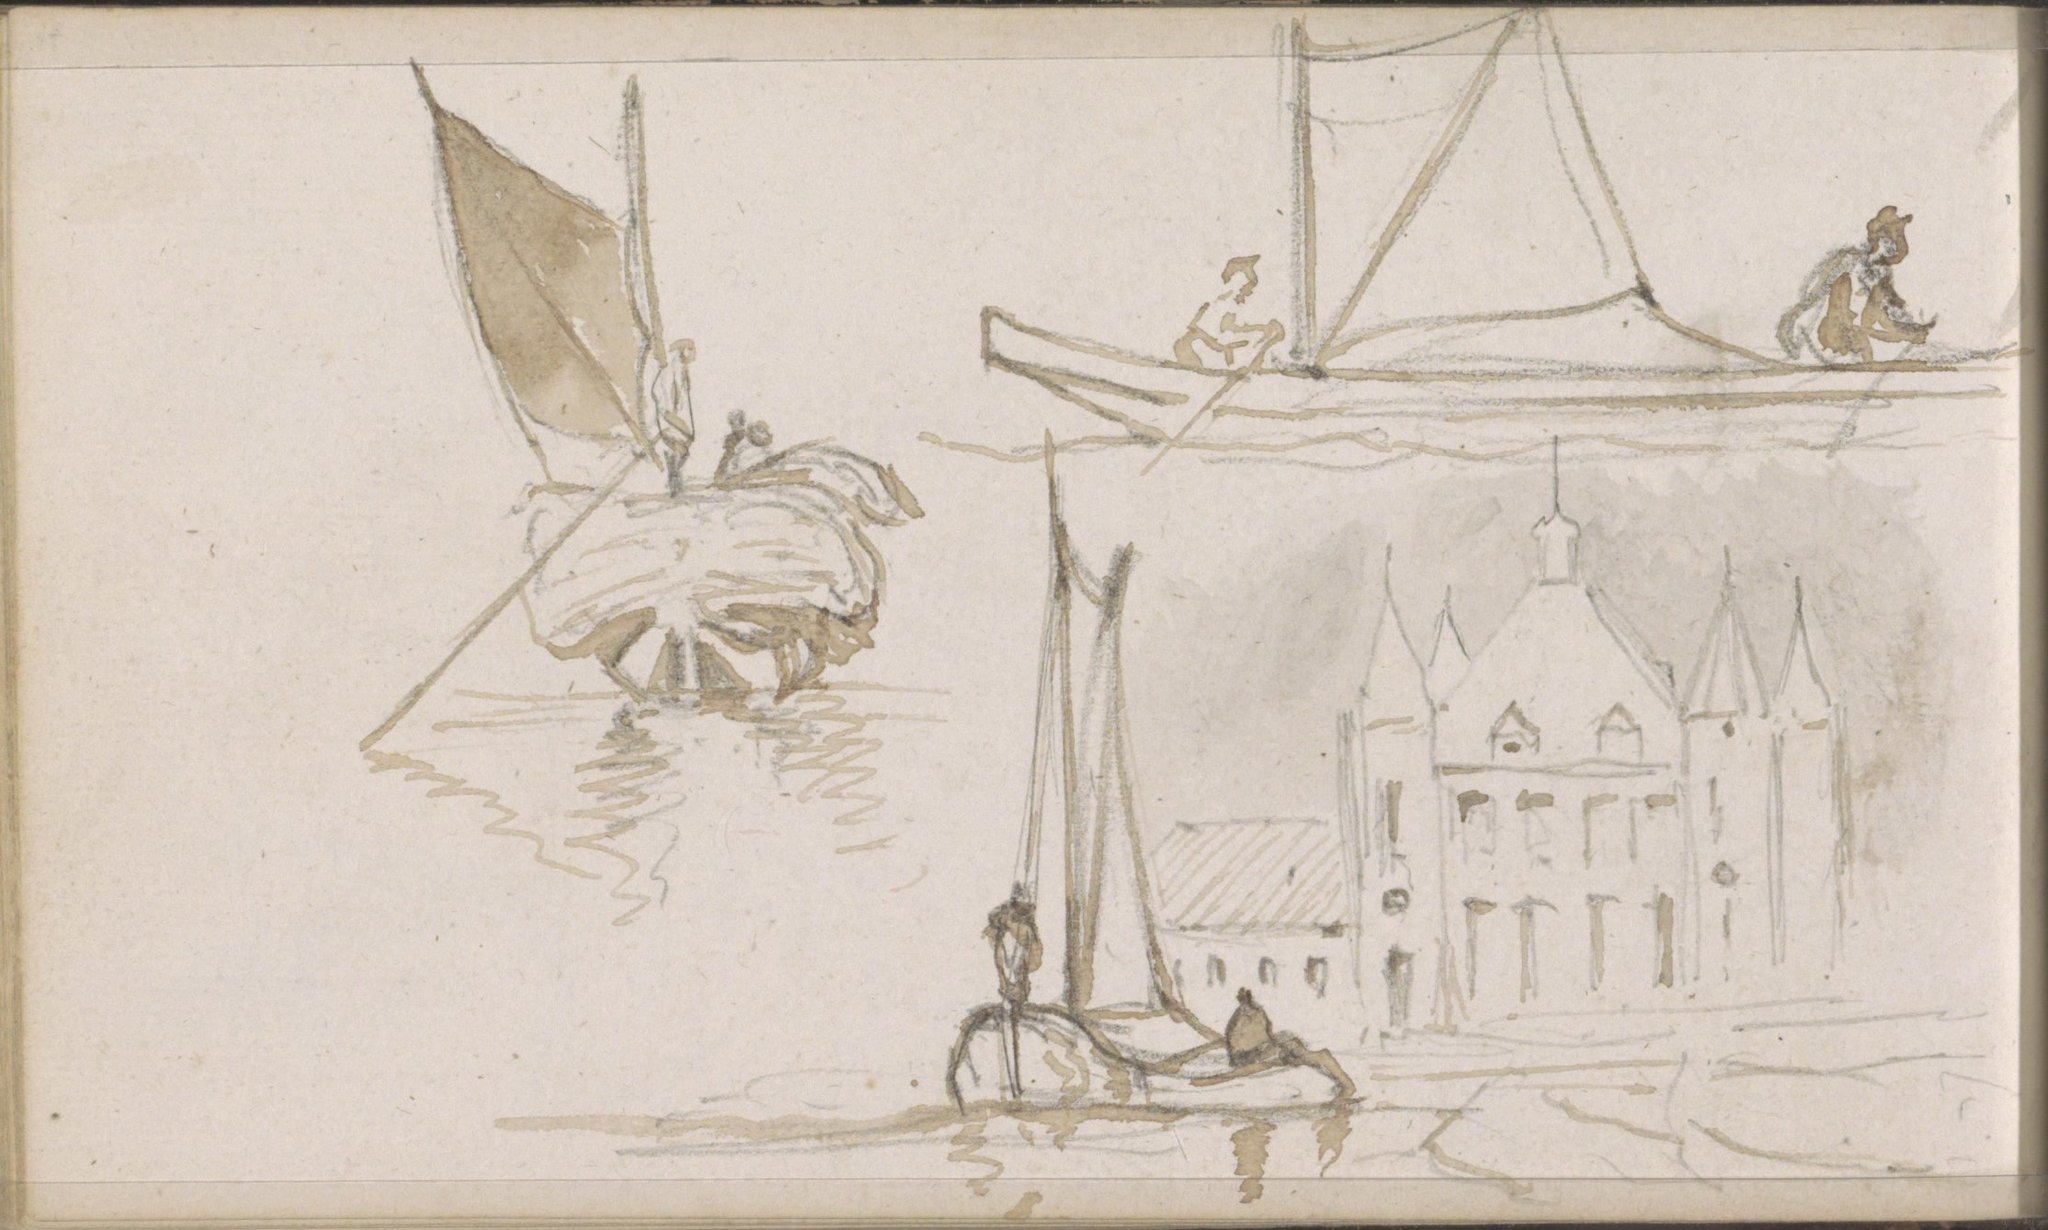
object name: sketchbook leaf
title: Zeilschepen op een rivier bij een gebouw met vijf torens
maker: johannes tavenraat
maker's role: draughtsman, painter, print maker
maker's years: 1809-1881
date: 1864-1880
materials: ink, paper, pencil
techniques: brush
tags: city-view, and landscape with man-made constructions, sailing-ship, sailing-boat, landscapes with waters, waterscapes, seascapes (in the temperate zone)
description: Blad 71 verso uit een schetsboek met 98 bladen.